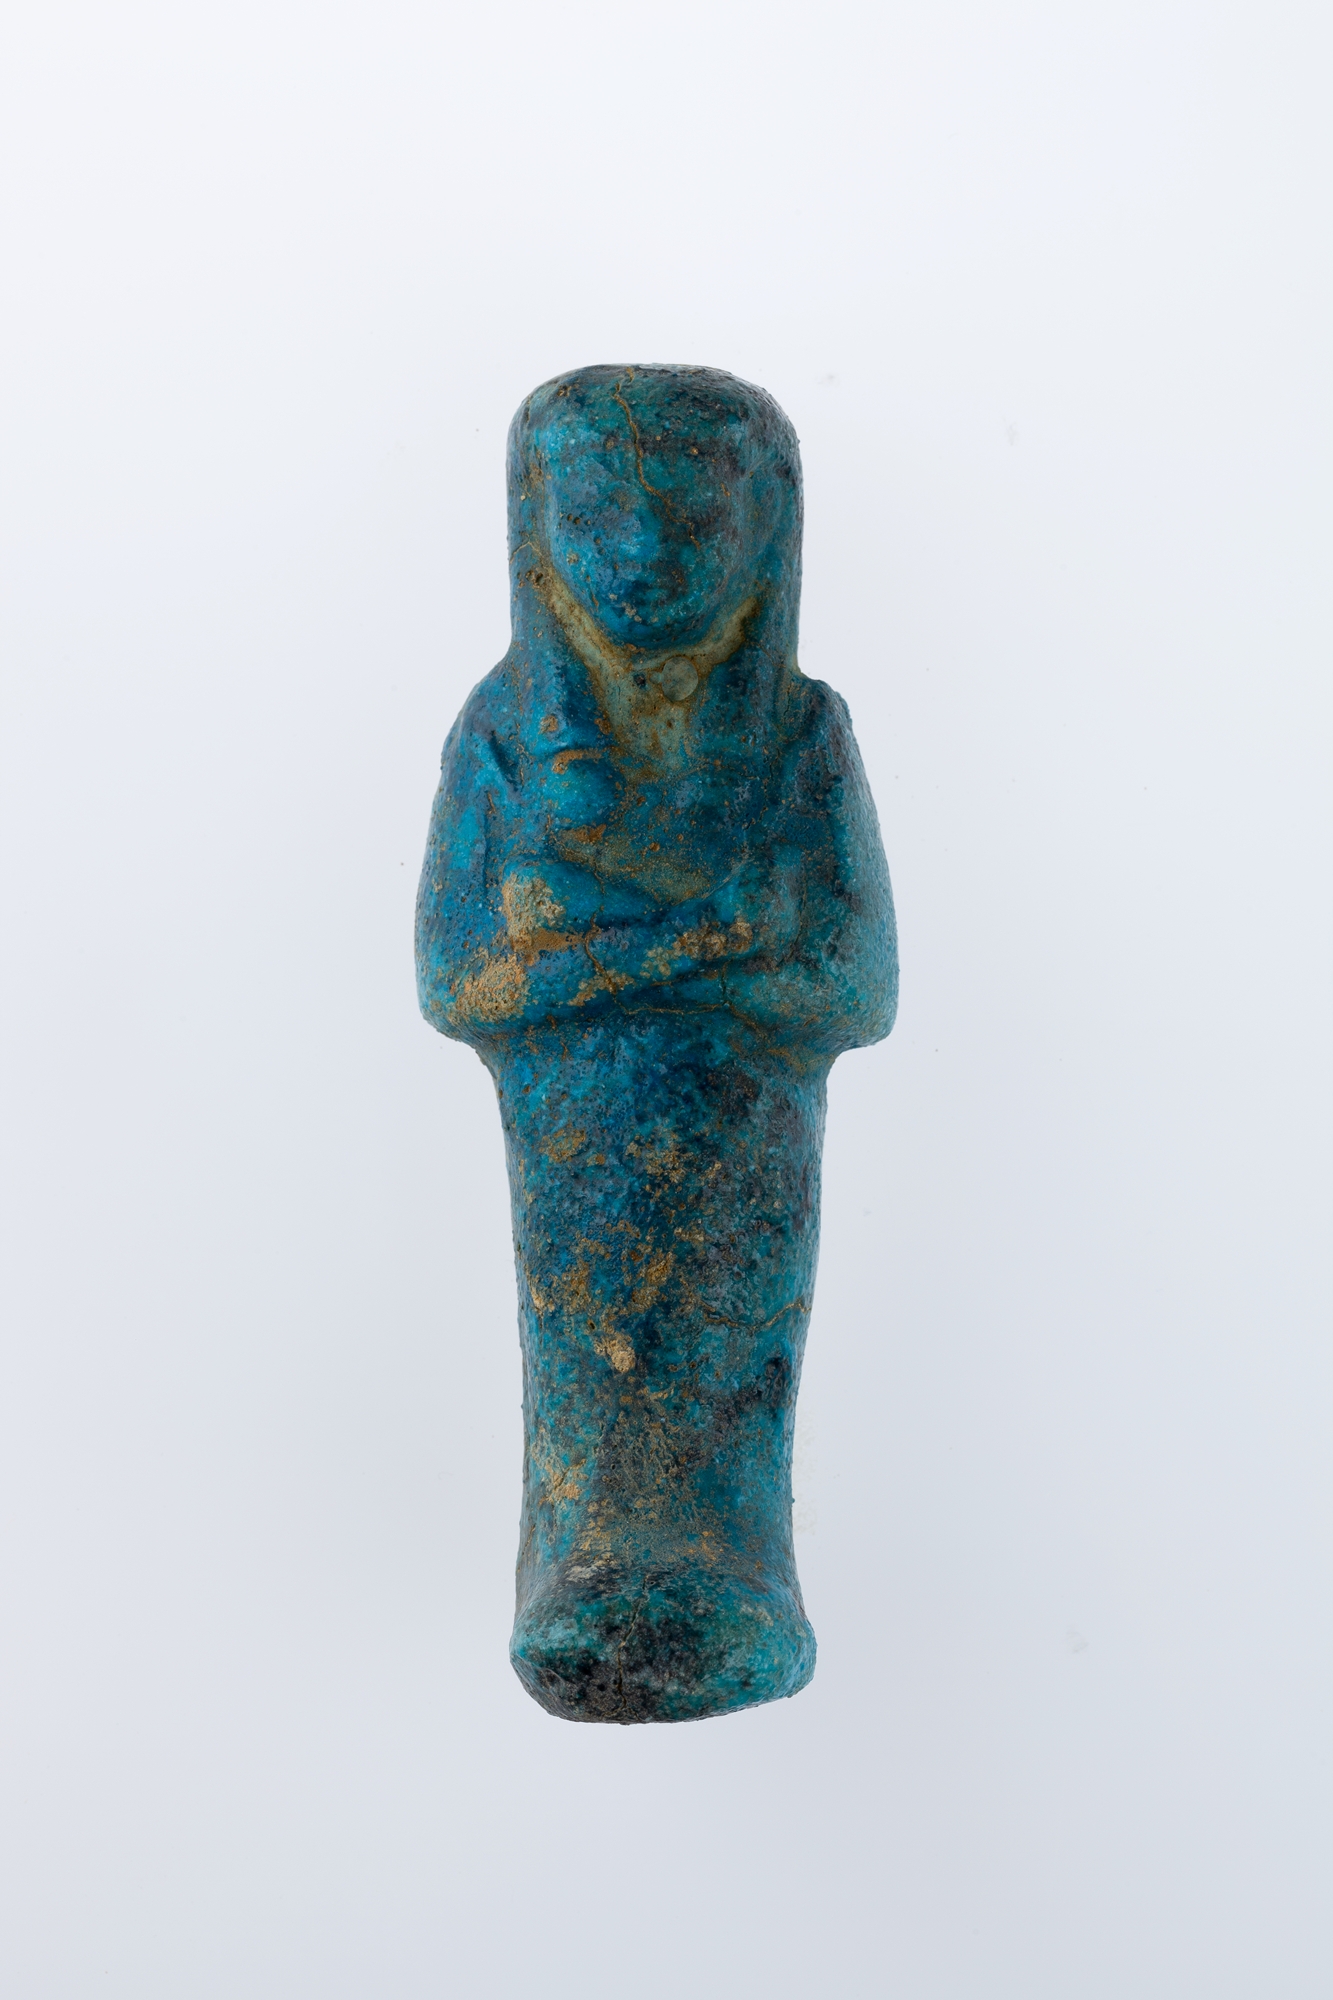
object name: shabti, henettawy c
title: Worker Shabti of Henettawy (C), Daughter of Isetemkheb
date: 990-970 BCE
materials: faience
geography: egypt